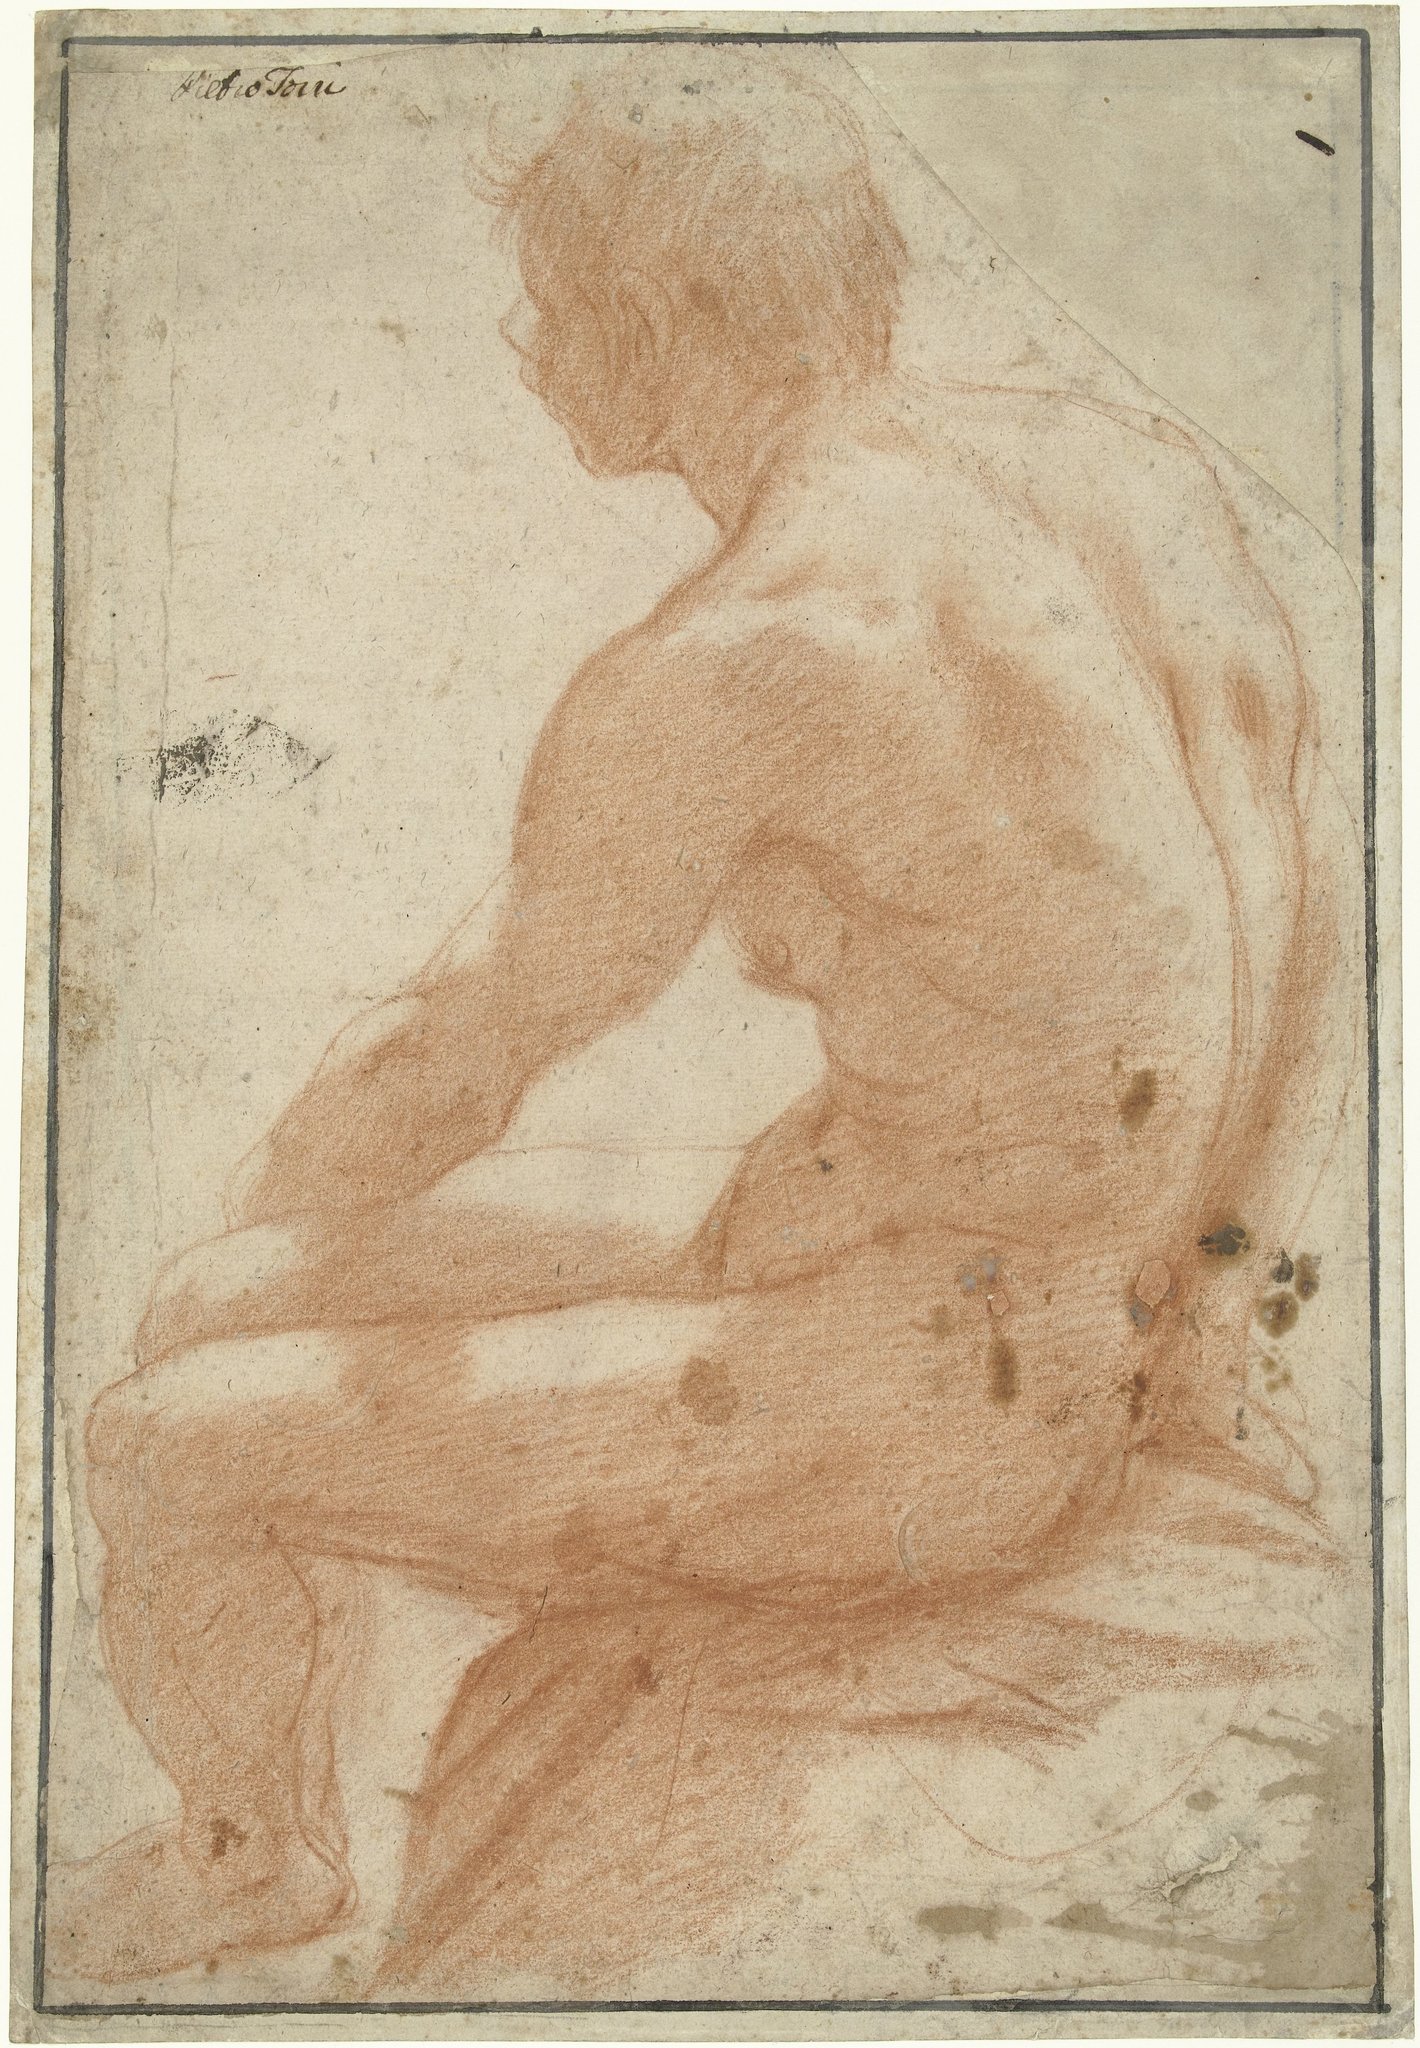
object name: drawing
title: Modelstudie van een zittende man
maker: pietro sorri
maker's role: draughtsman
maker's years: 1556-1622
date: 1609-1614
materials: chalk, paper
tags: sitting figure